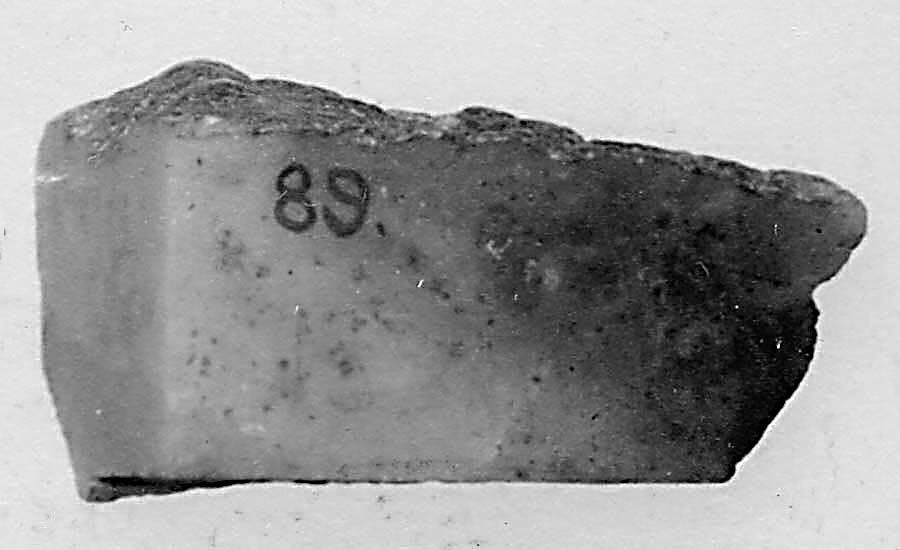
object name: fragment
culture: chinese or turkestani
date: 1902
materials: jade